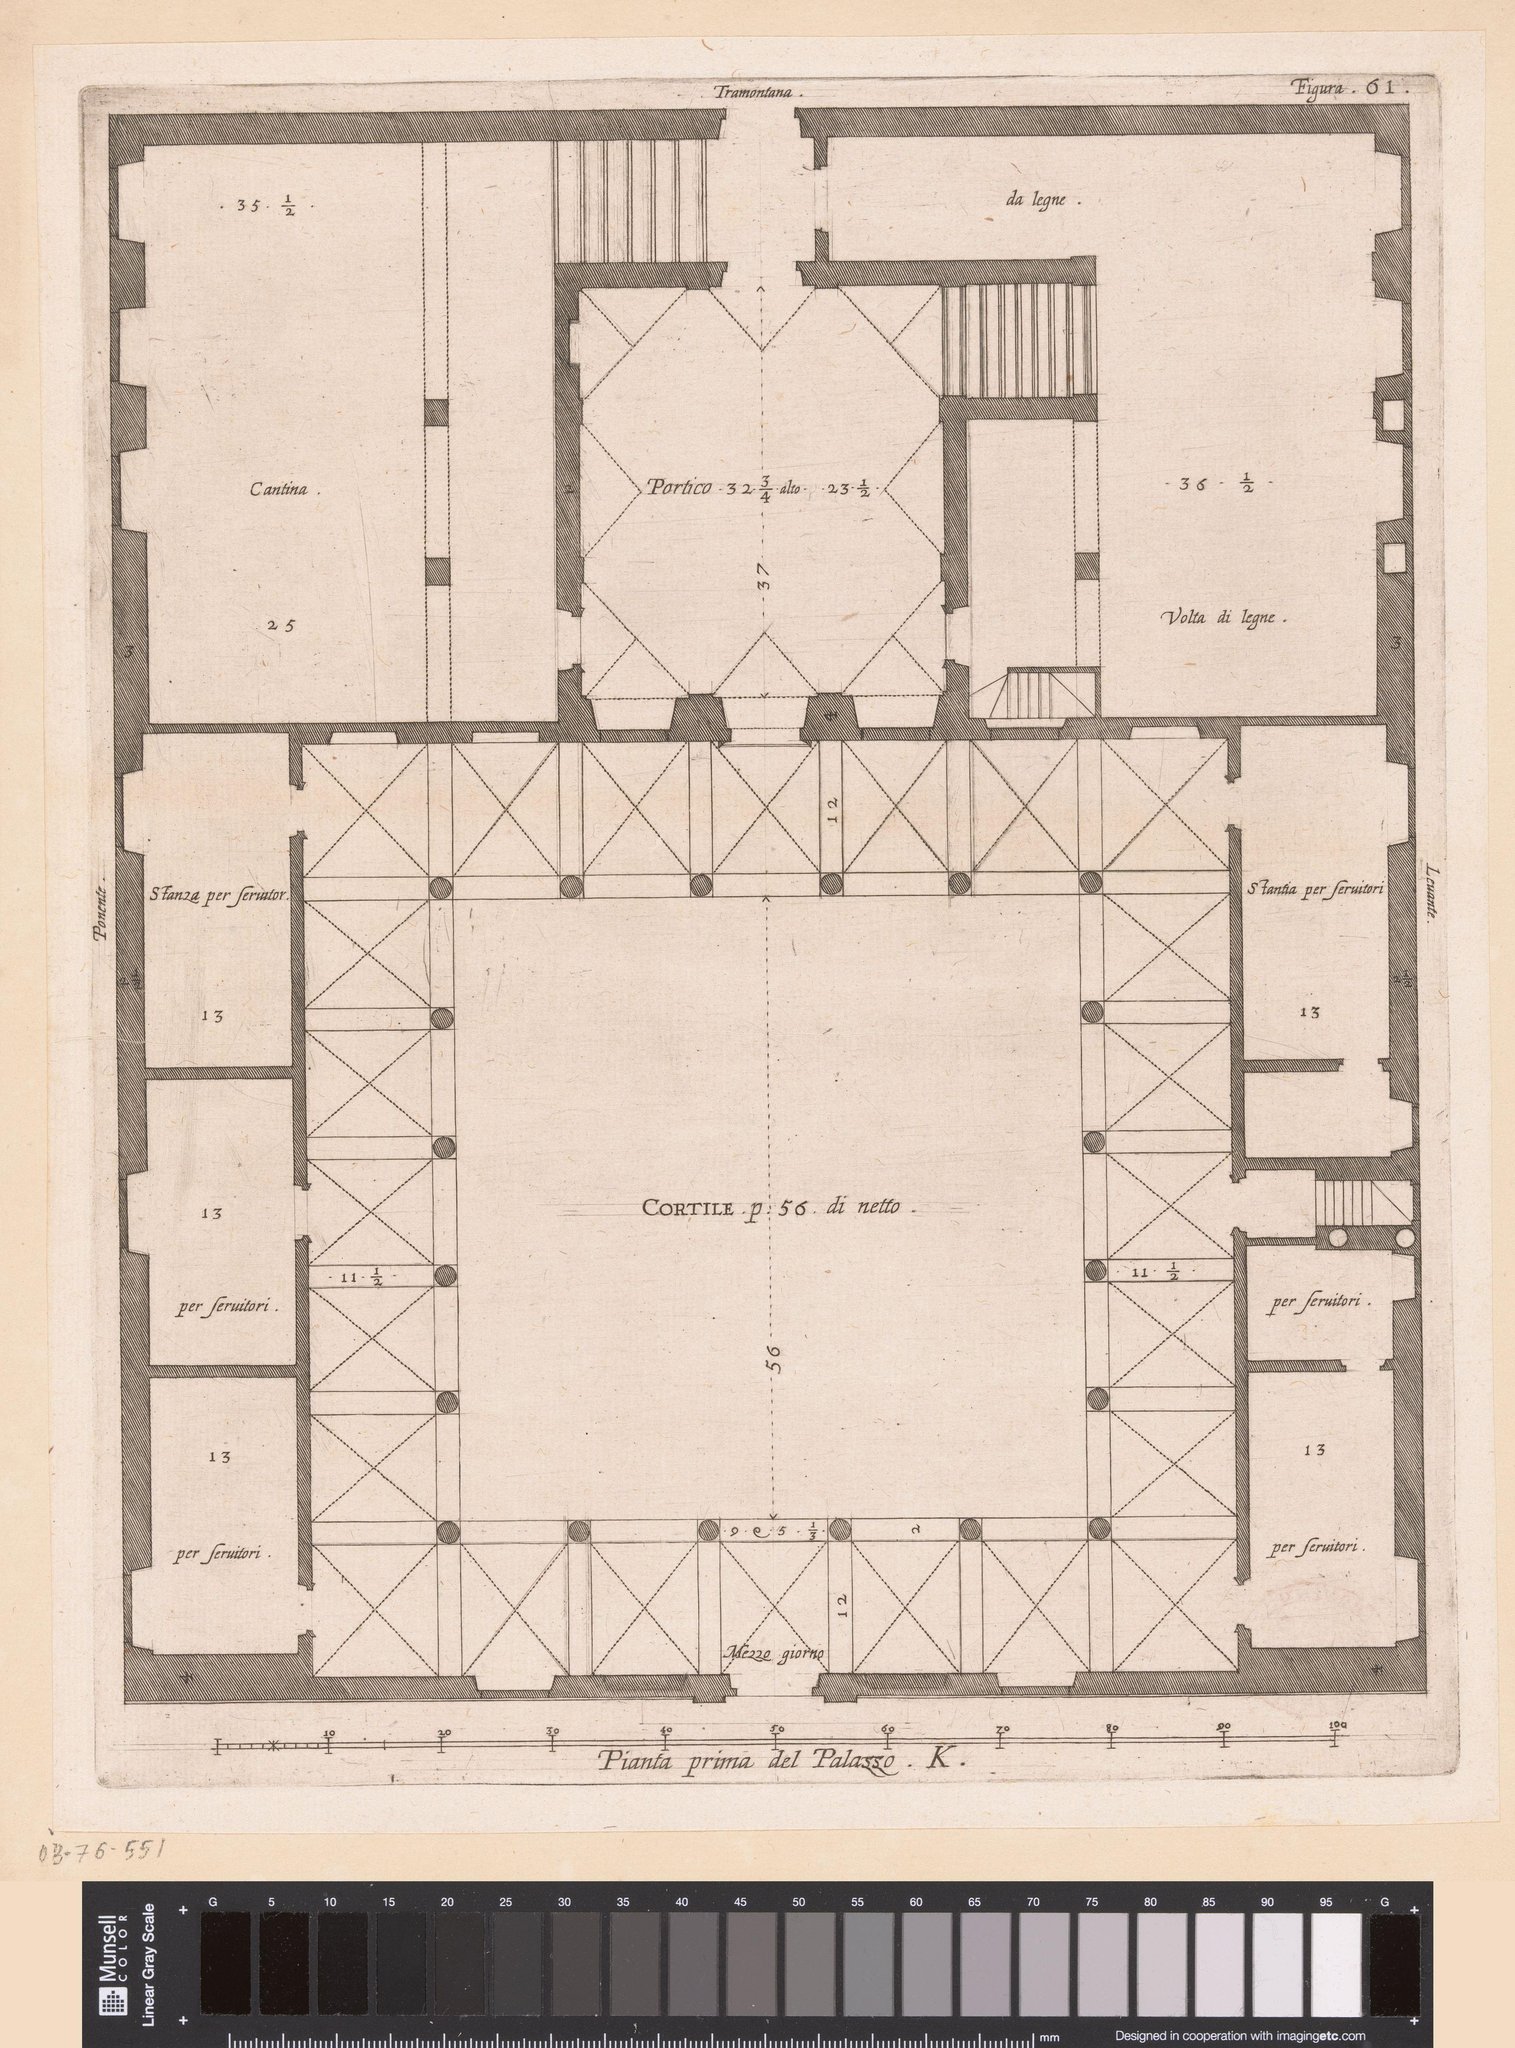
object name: print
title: Plattegrond van de begane grond van het Palazzo Lercari-Parodi te Genua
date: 1622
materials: paper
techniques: engraving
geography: antwerp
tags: hôtel, i.e. small palace in city - aa - civic architecture: inside, plan ~ architecture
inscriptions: collector's mark: Lugt 240